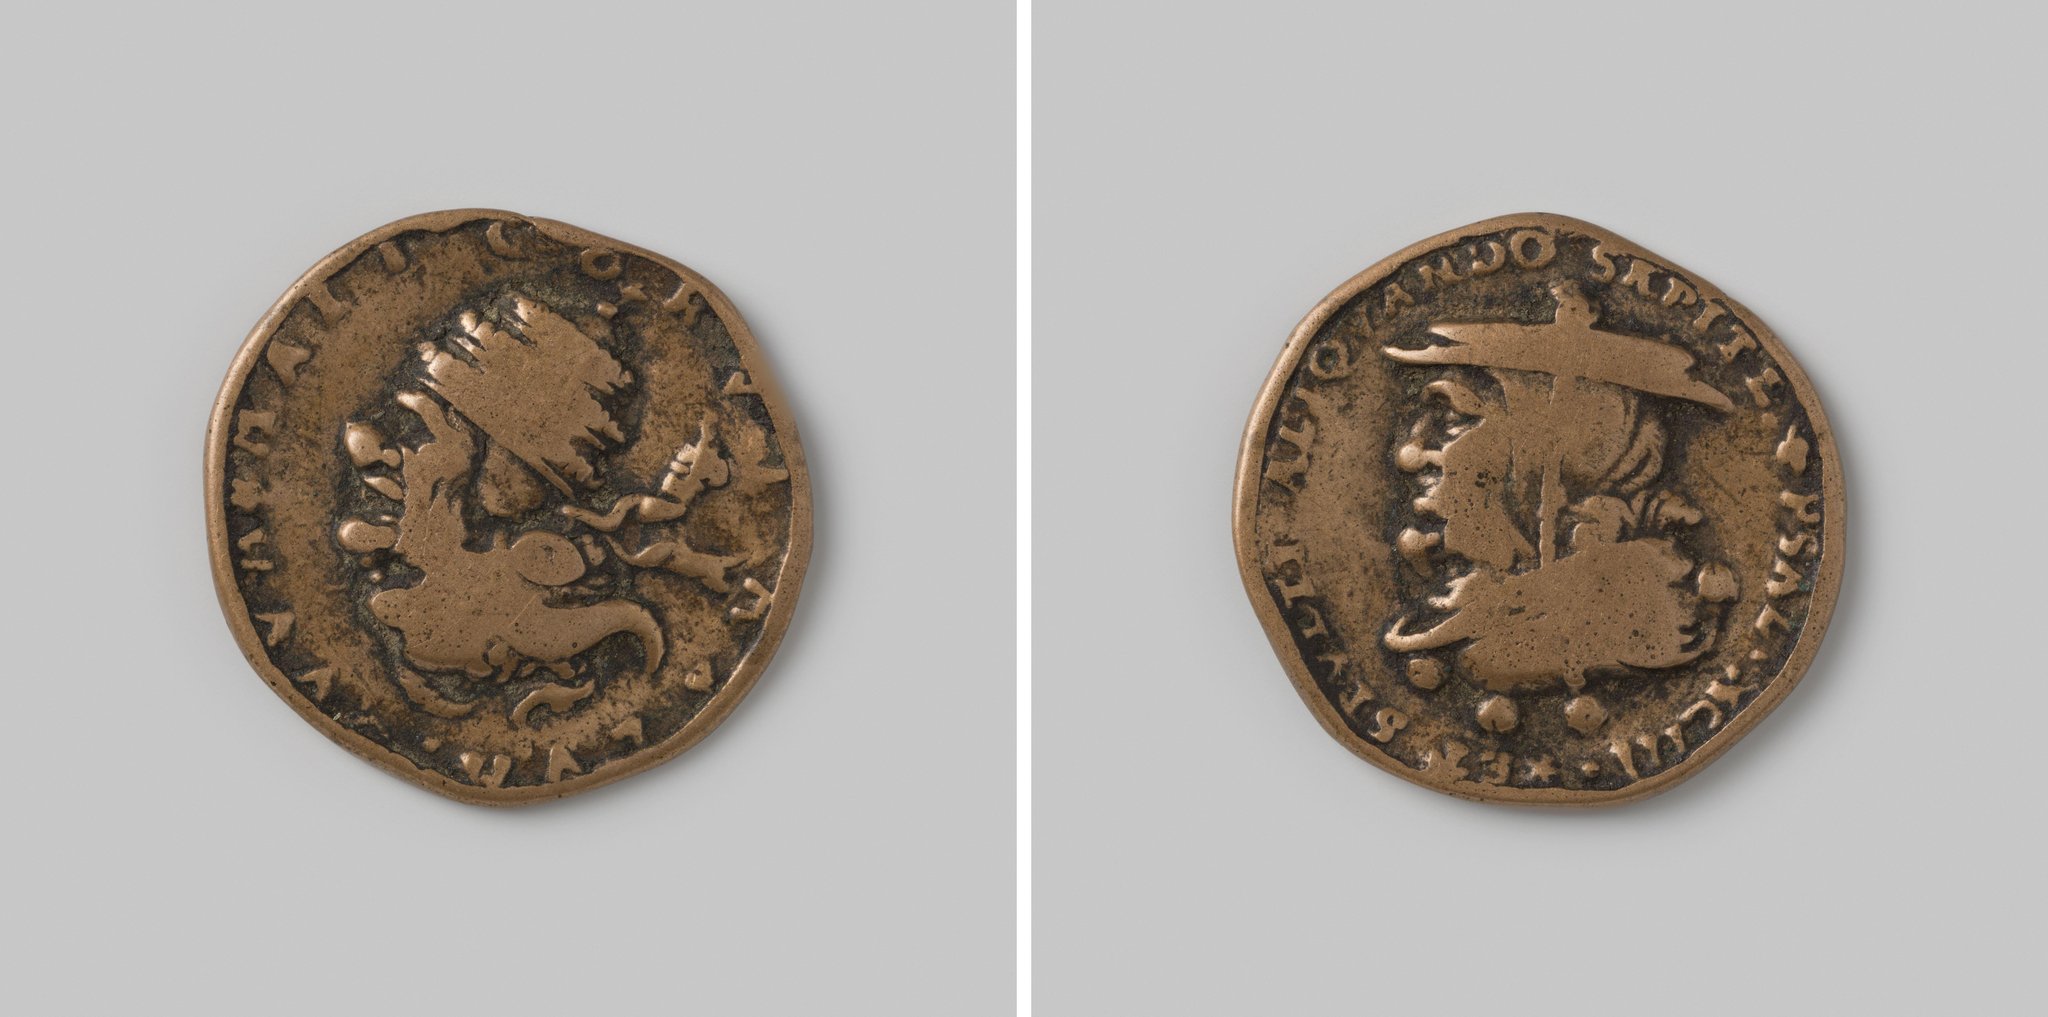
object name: history medal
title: Spotpenning op de Paus en de Rooms-Katholieke clerus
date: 1543-1648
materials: brass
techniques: casting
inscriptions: circumscription: ‘STULTI ALIQVANDO SAPITE PSAL XCIIII’, circumscription: ‘MALI CORVI MALVM OVVM’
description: Messing penning, op de voorzijde het portret van de Paus naar links draaibaar tot dat van de duivel naar rechts, met omschrift, op de keerzijde het portret van een kardinaal naar links draaibaar tot dat van een nar naar rechts, met omschrift.